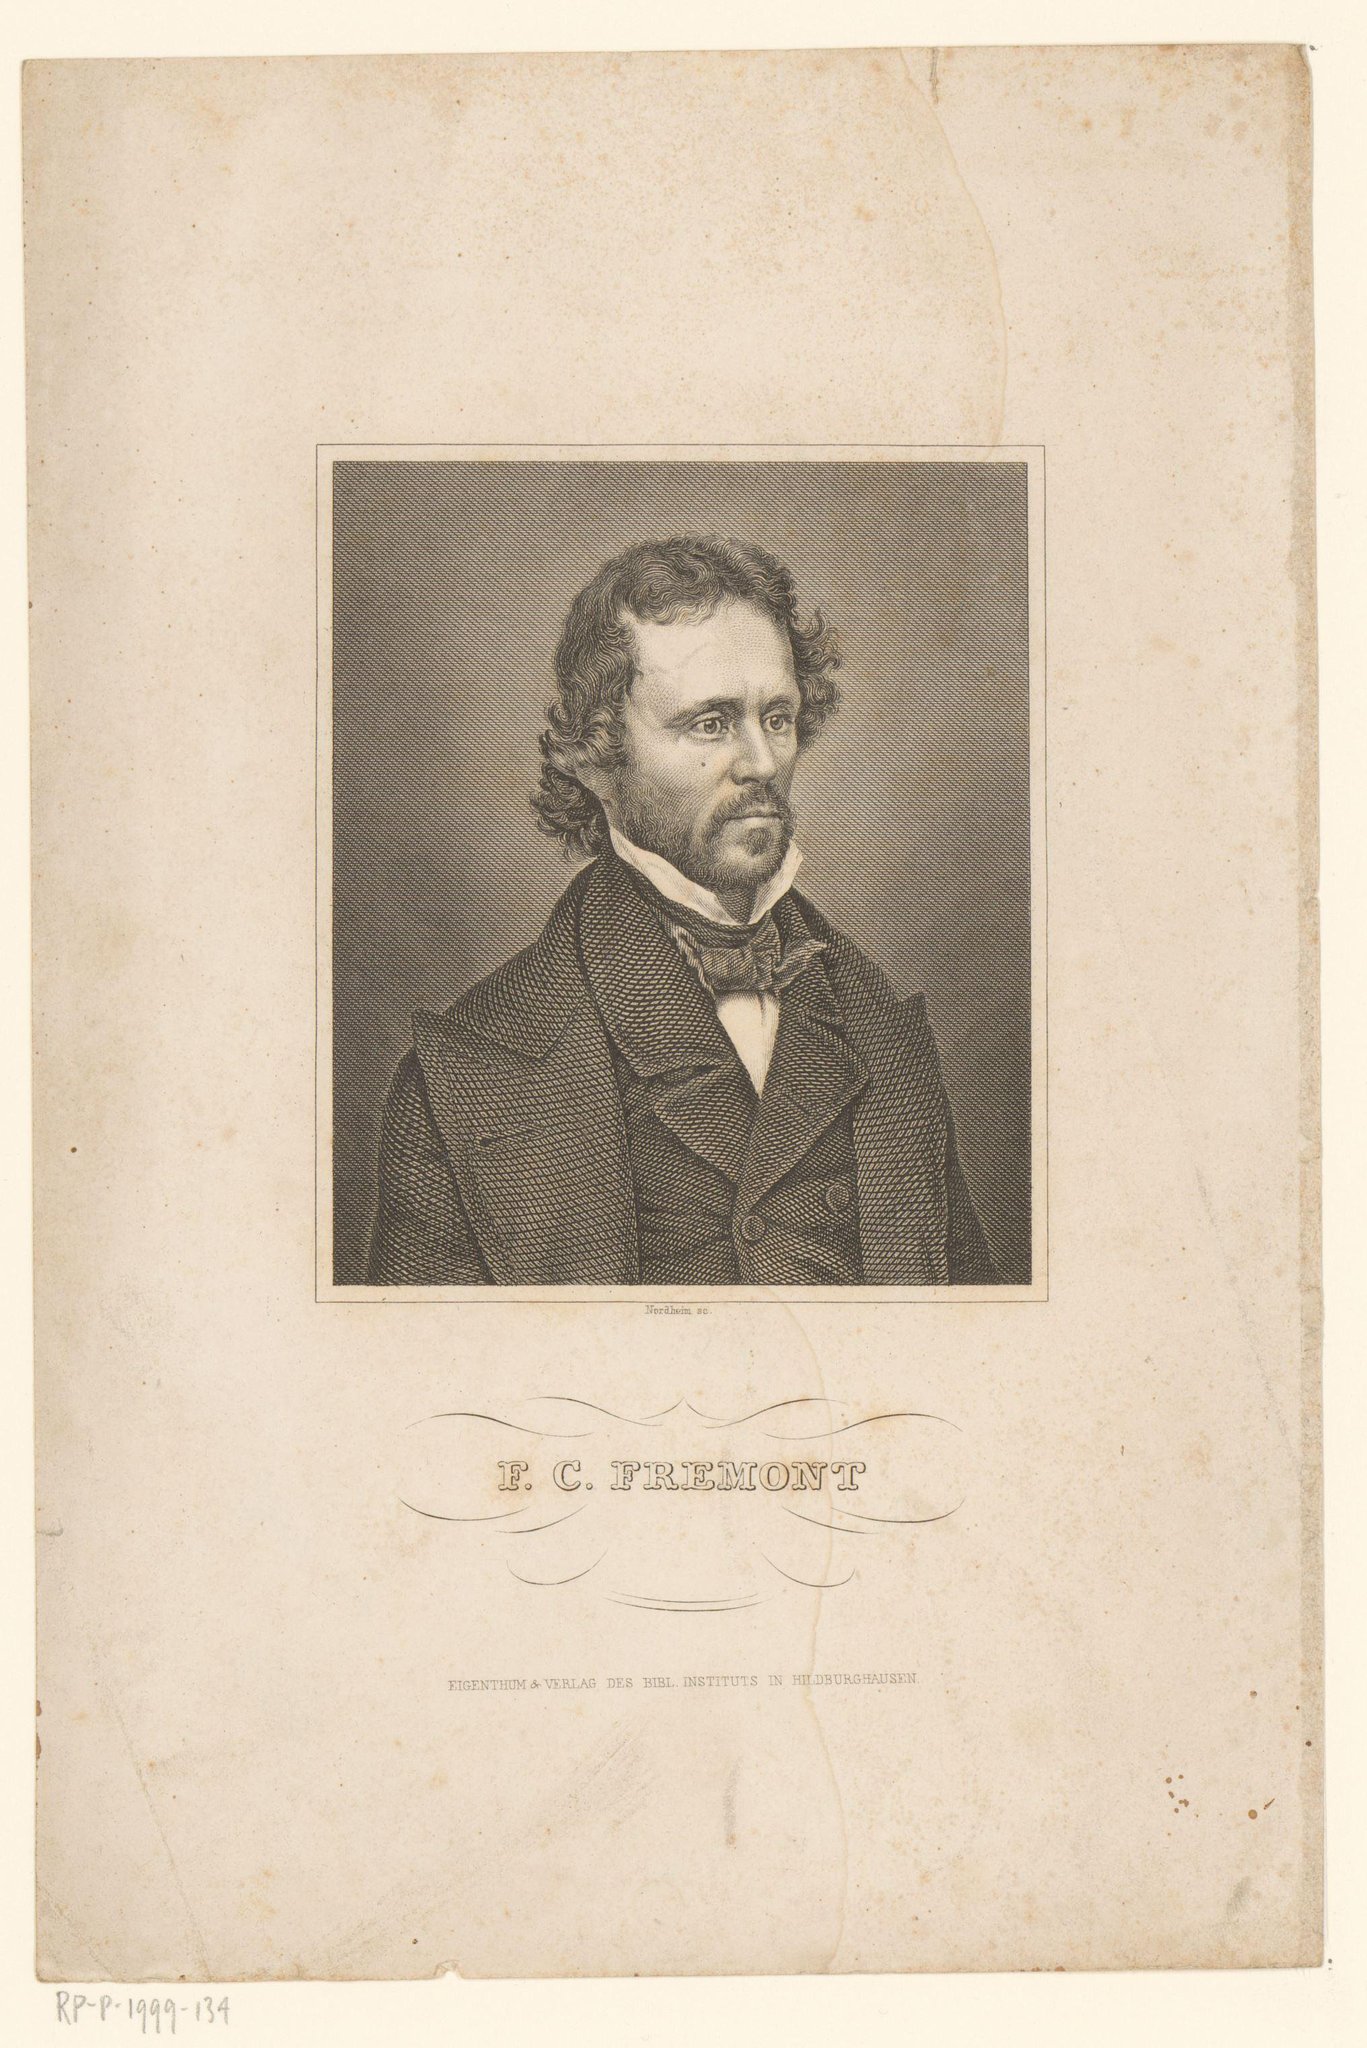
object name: print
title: Portret John Charles Frémont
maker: johann georg nordheim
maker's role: print maker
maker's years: 1804-1853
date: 1819-1853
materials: paper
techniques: engraving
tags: new york (city), politician, historical persons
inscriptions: collector's mark: Lugt 2228